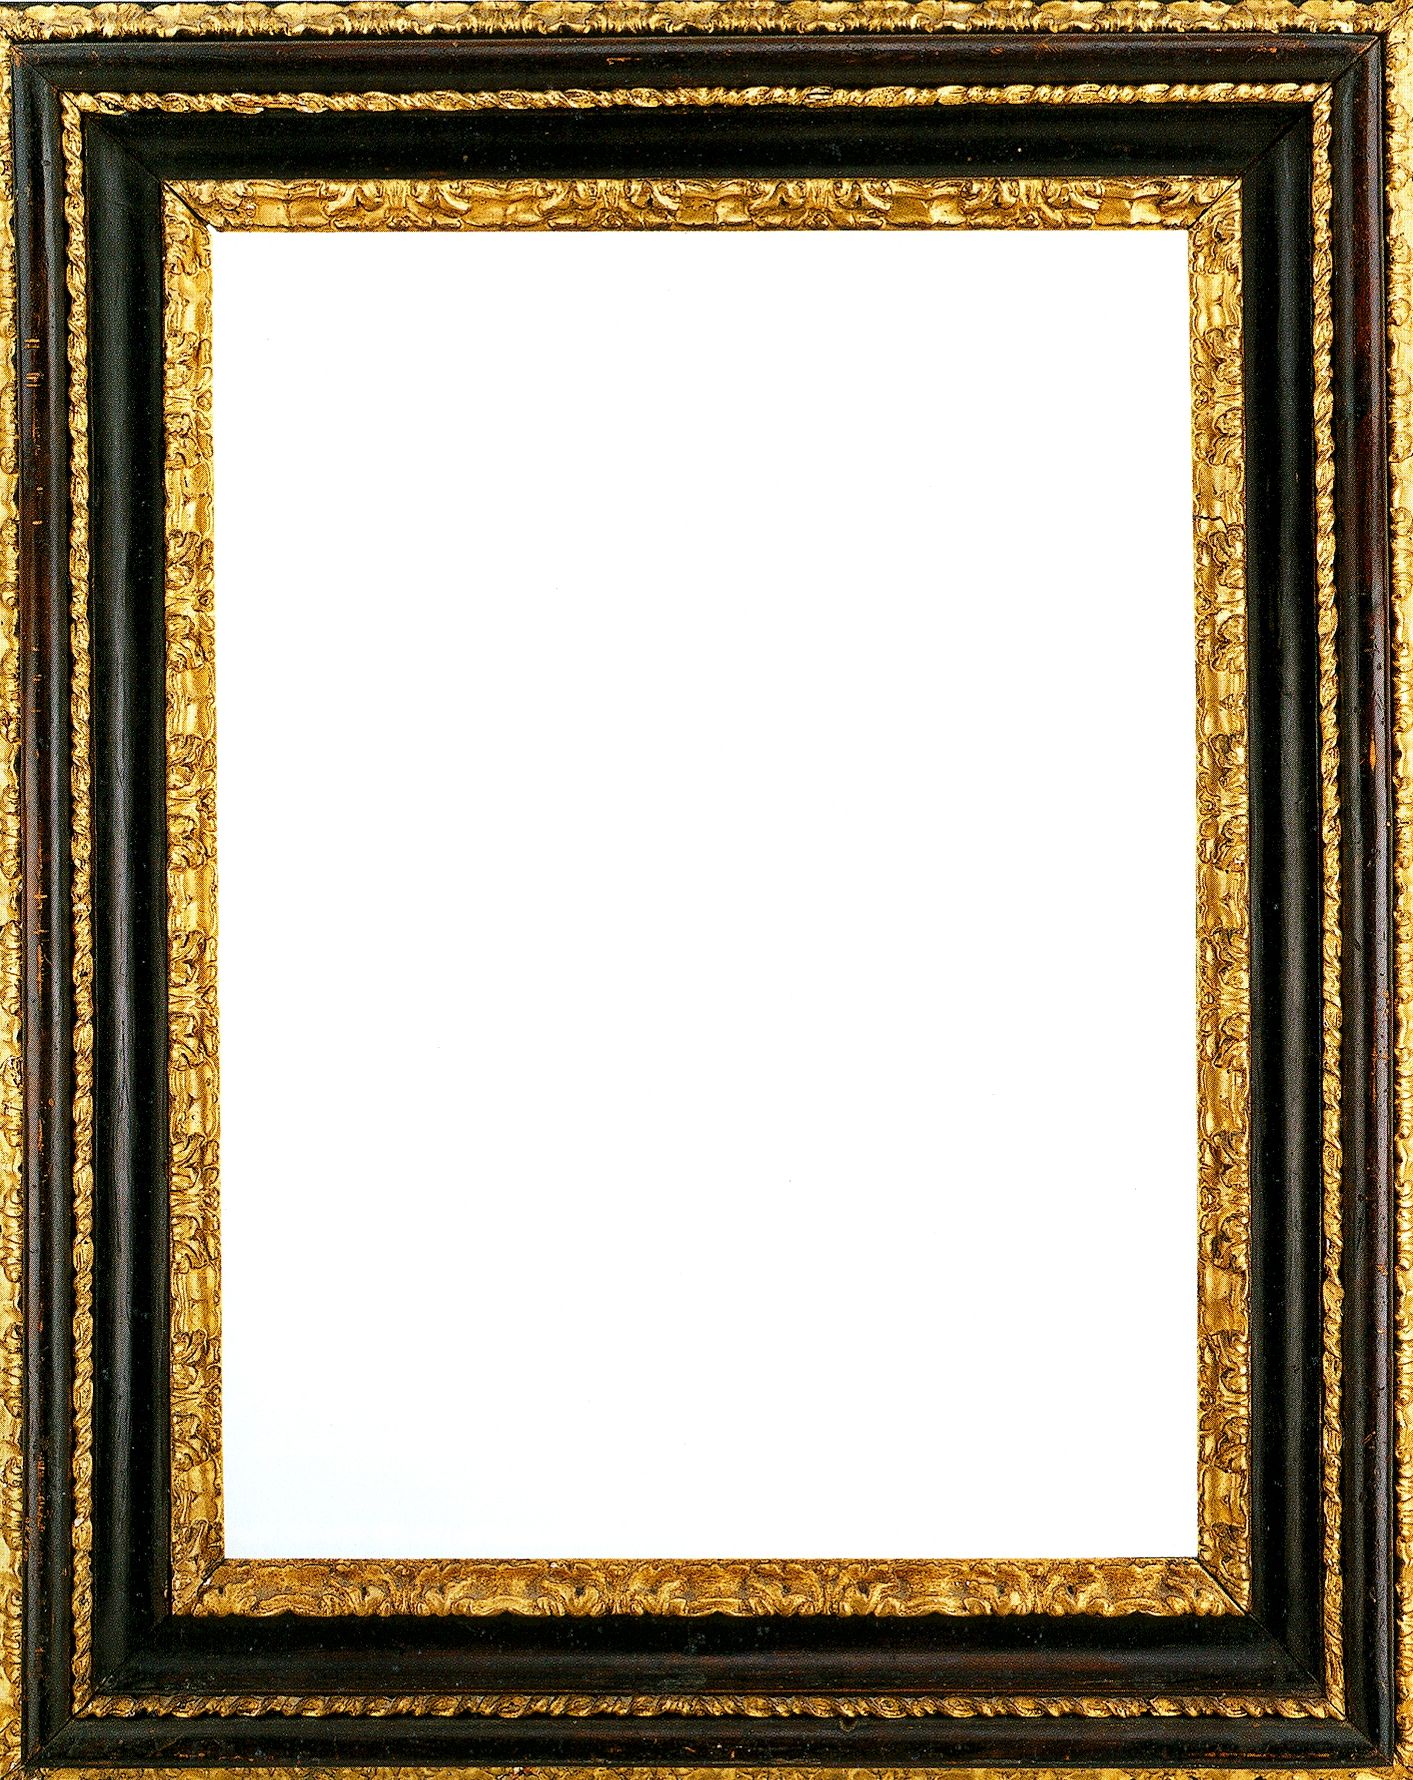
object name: frame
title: Salvator Rosa frame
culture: italian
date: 1667-1700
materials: wood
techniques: polish